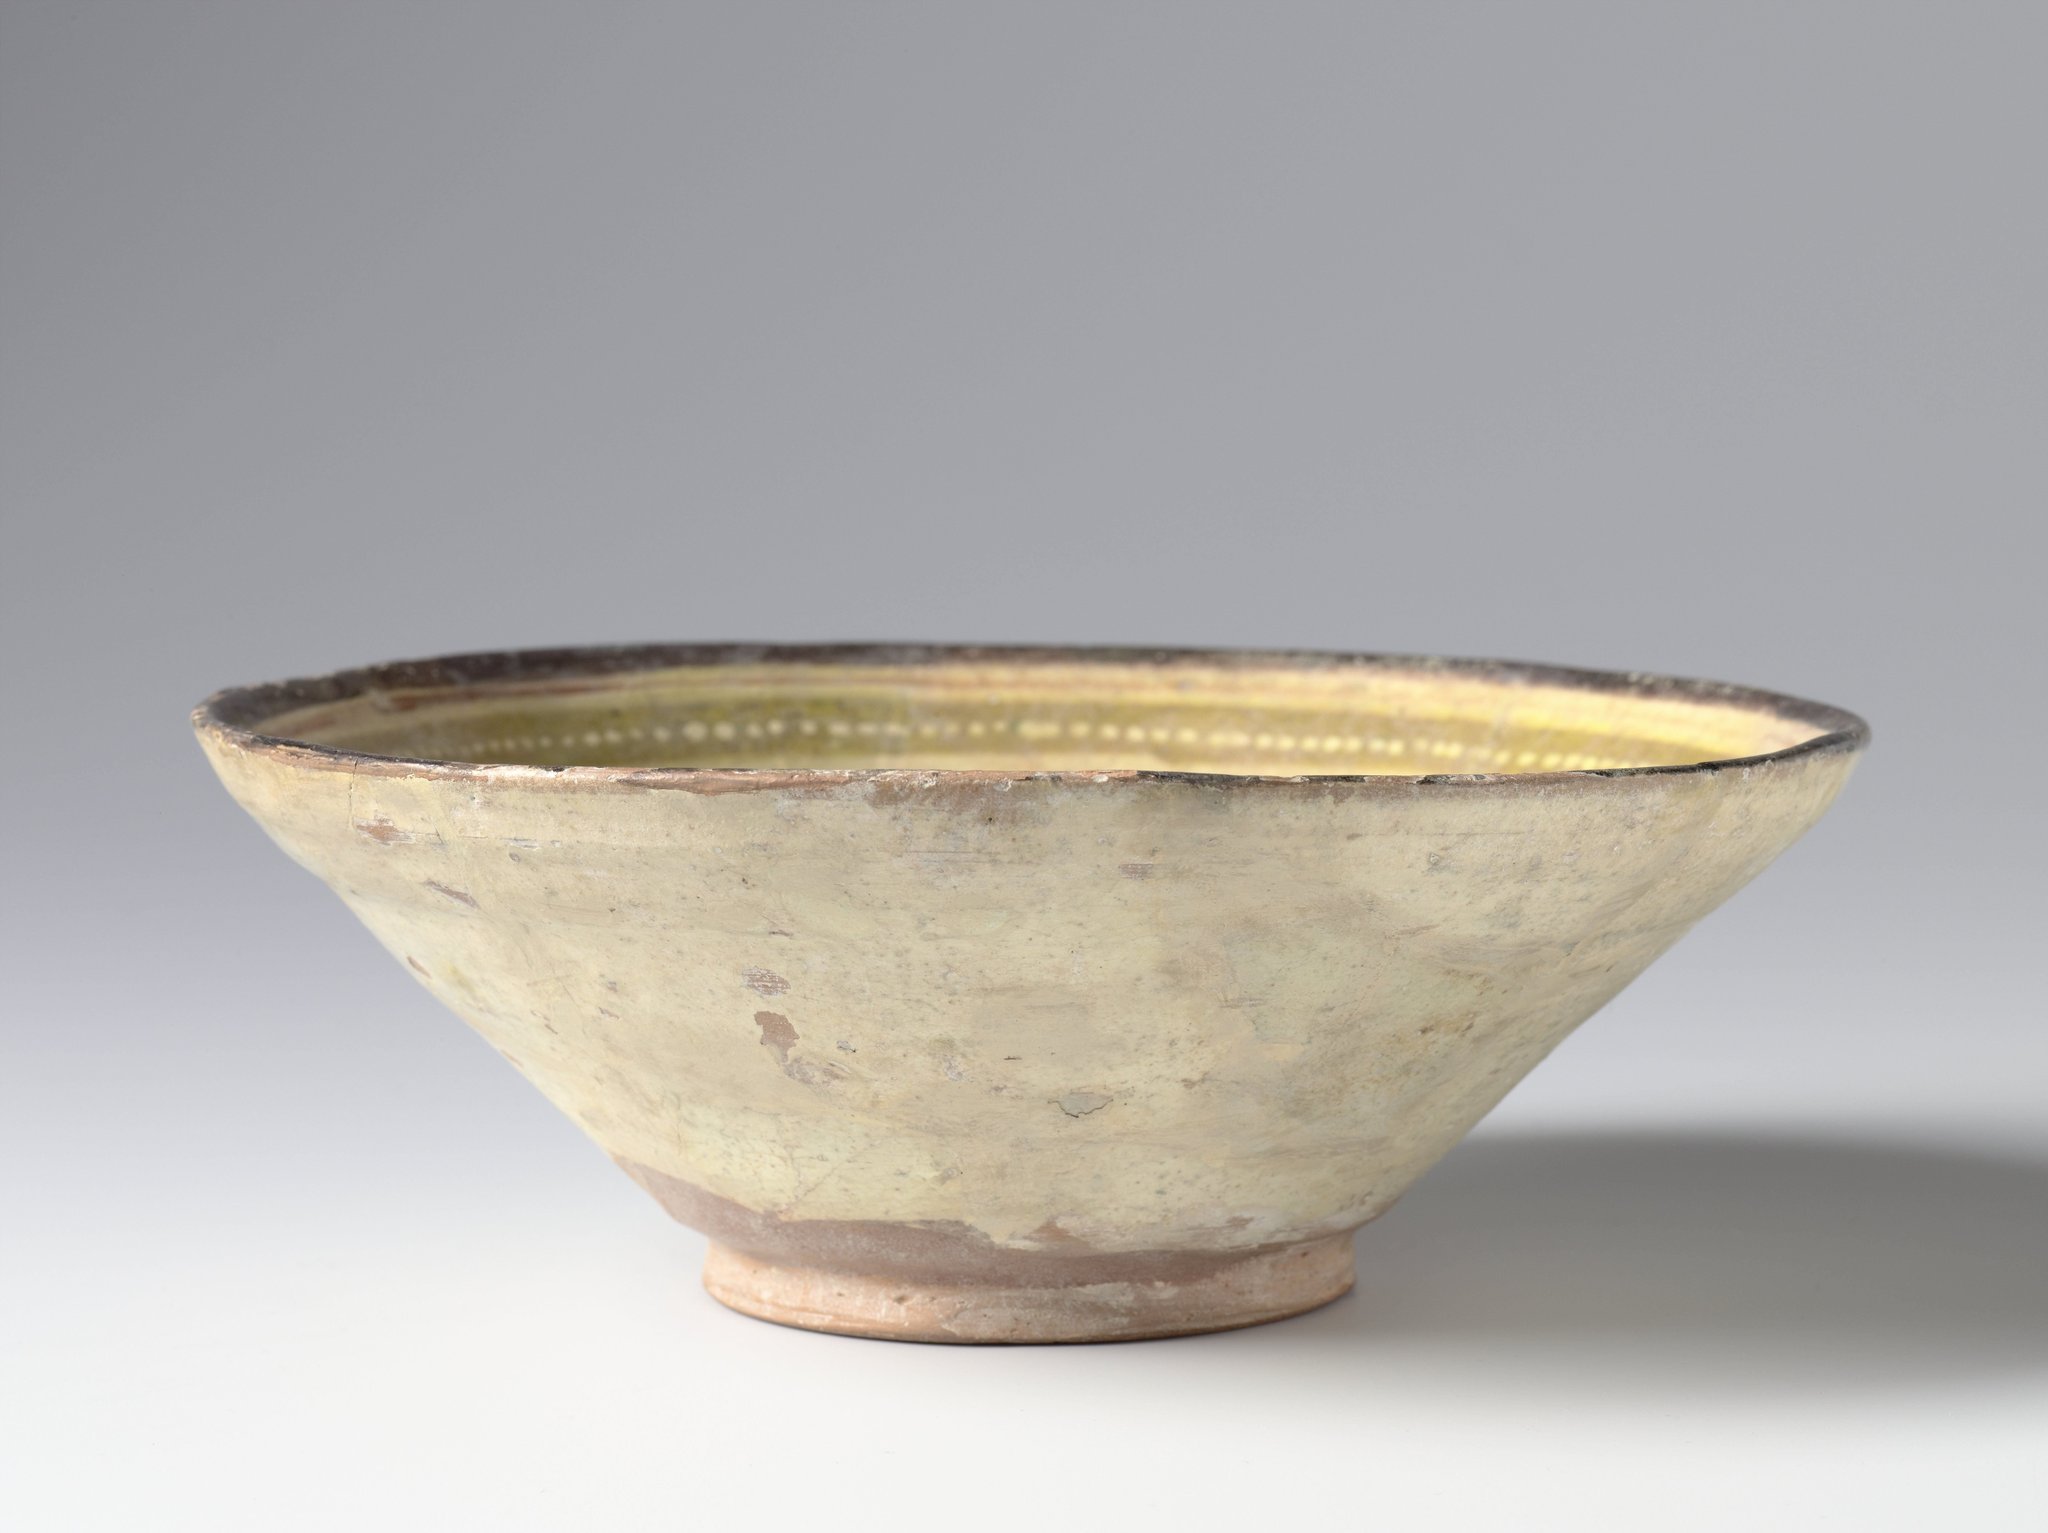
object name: bowl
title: Bowl with a deer and a pseudo-inscription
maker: Anonymous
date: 900-999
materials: earthenware, glaze, paint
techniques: firing, turning, vitrification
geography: nishapur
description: Aardewerken kom, gedecoreerd met mangaanbruin en gele, groene en rode slib op een engobe van witte slib onder transparant loodglazuur. Op de binnenwand een hert en een band pseudo-schrift.